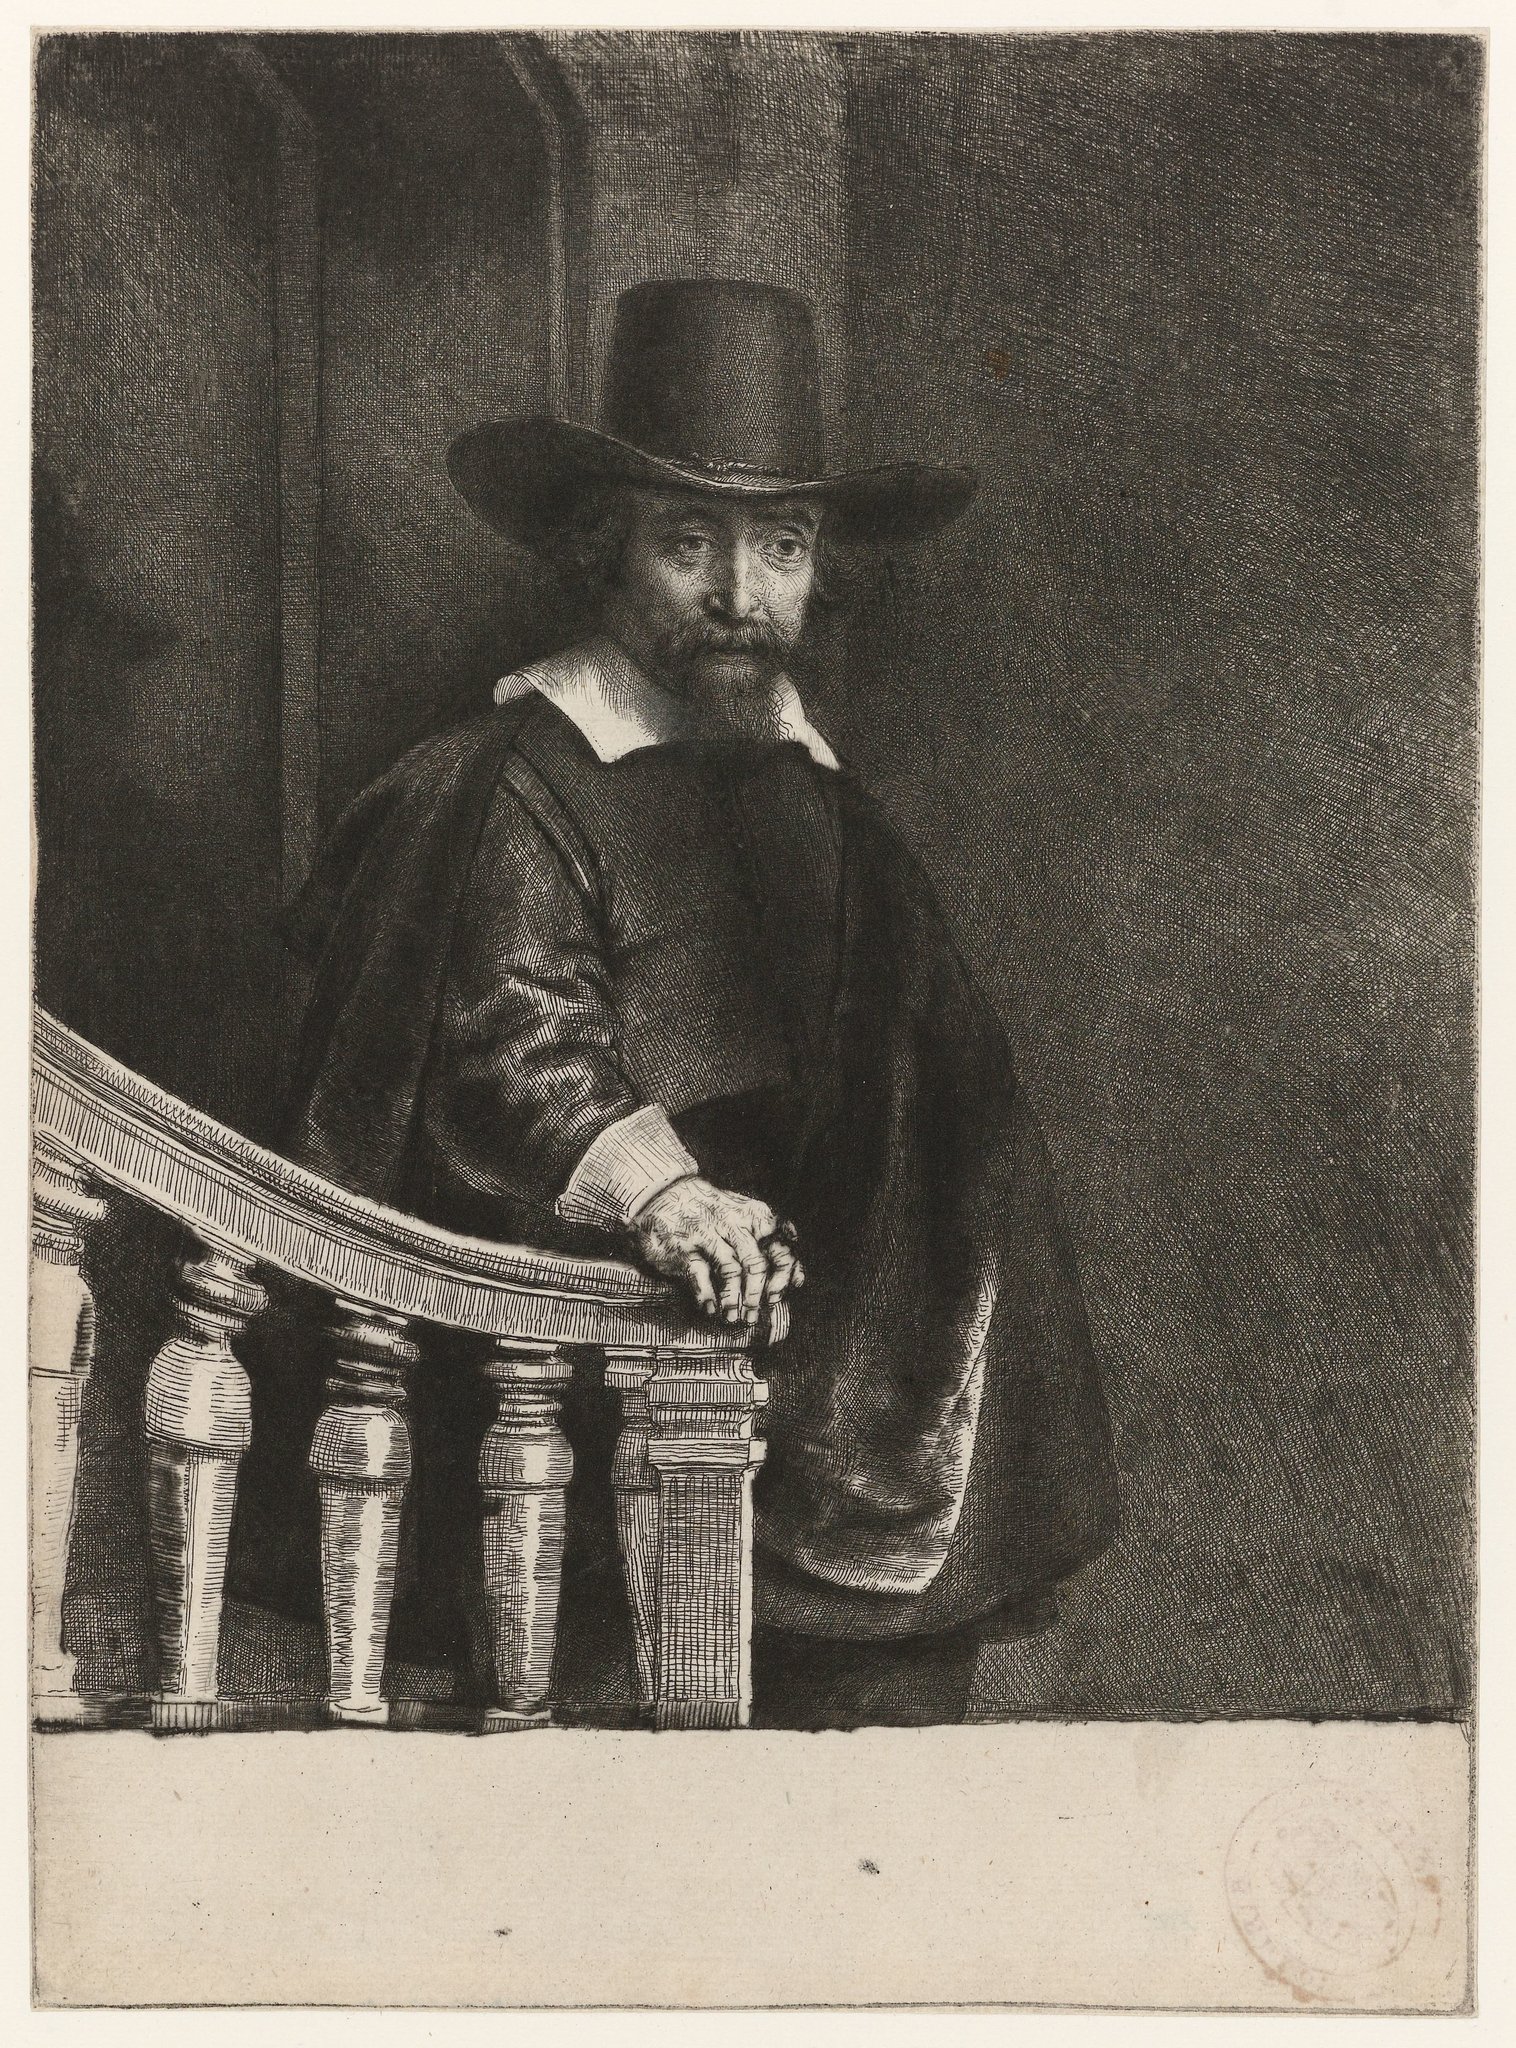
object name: print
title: Ephraim Bonus, Jewish physician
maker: rembrandt van rijn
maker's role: draughtsman, painter, print maker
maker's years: 1606-1669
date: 1647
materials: paper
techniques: drypoint, etching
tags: amsterdam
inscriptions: collector's mark: Lugt 240, signature and date: ‘Rembrandt f 1647’